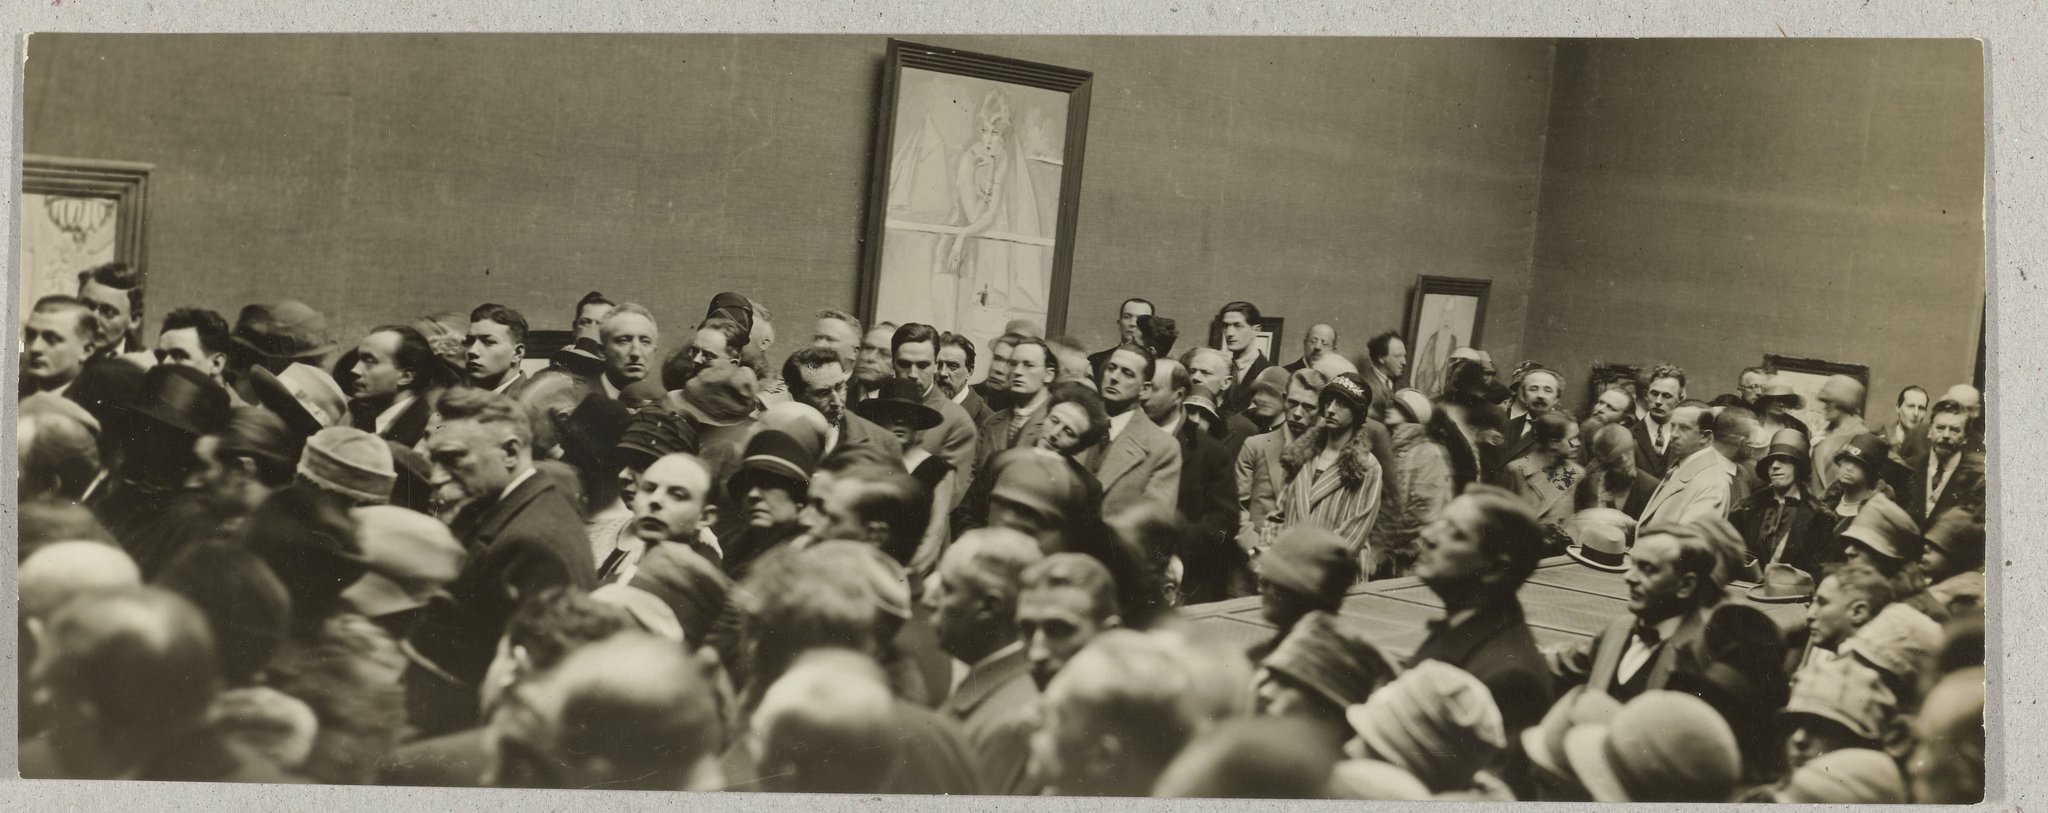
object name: photograph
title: Opening van een tentoonstelling van schilderijen van Kees van Dongen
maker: Anonymous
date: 1925-1940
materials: photographic support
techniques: gelatin silver print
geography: netherlands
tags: exhibition ~ art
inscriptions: annotation: ‘17 1/2 x 7 / Tent Kees van Dongen / D / Leven’